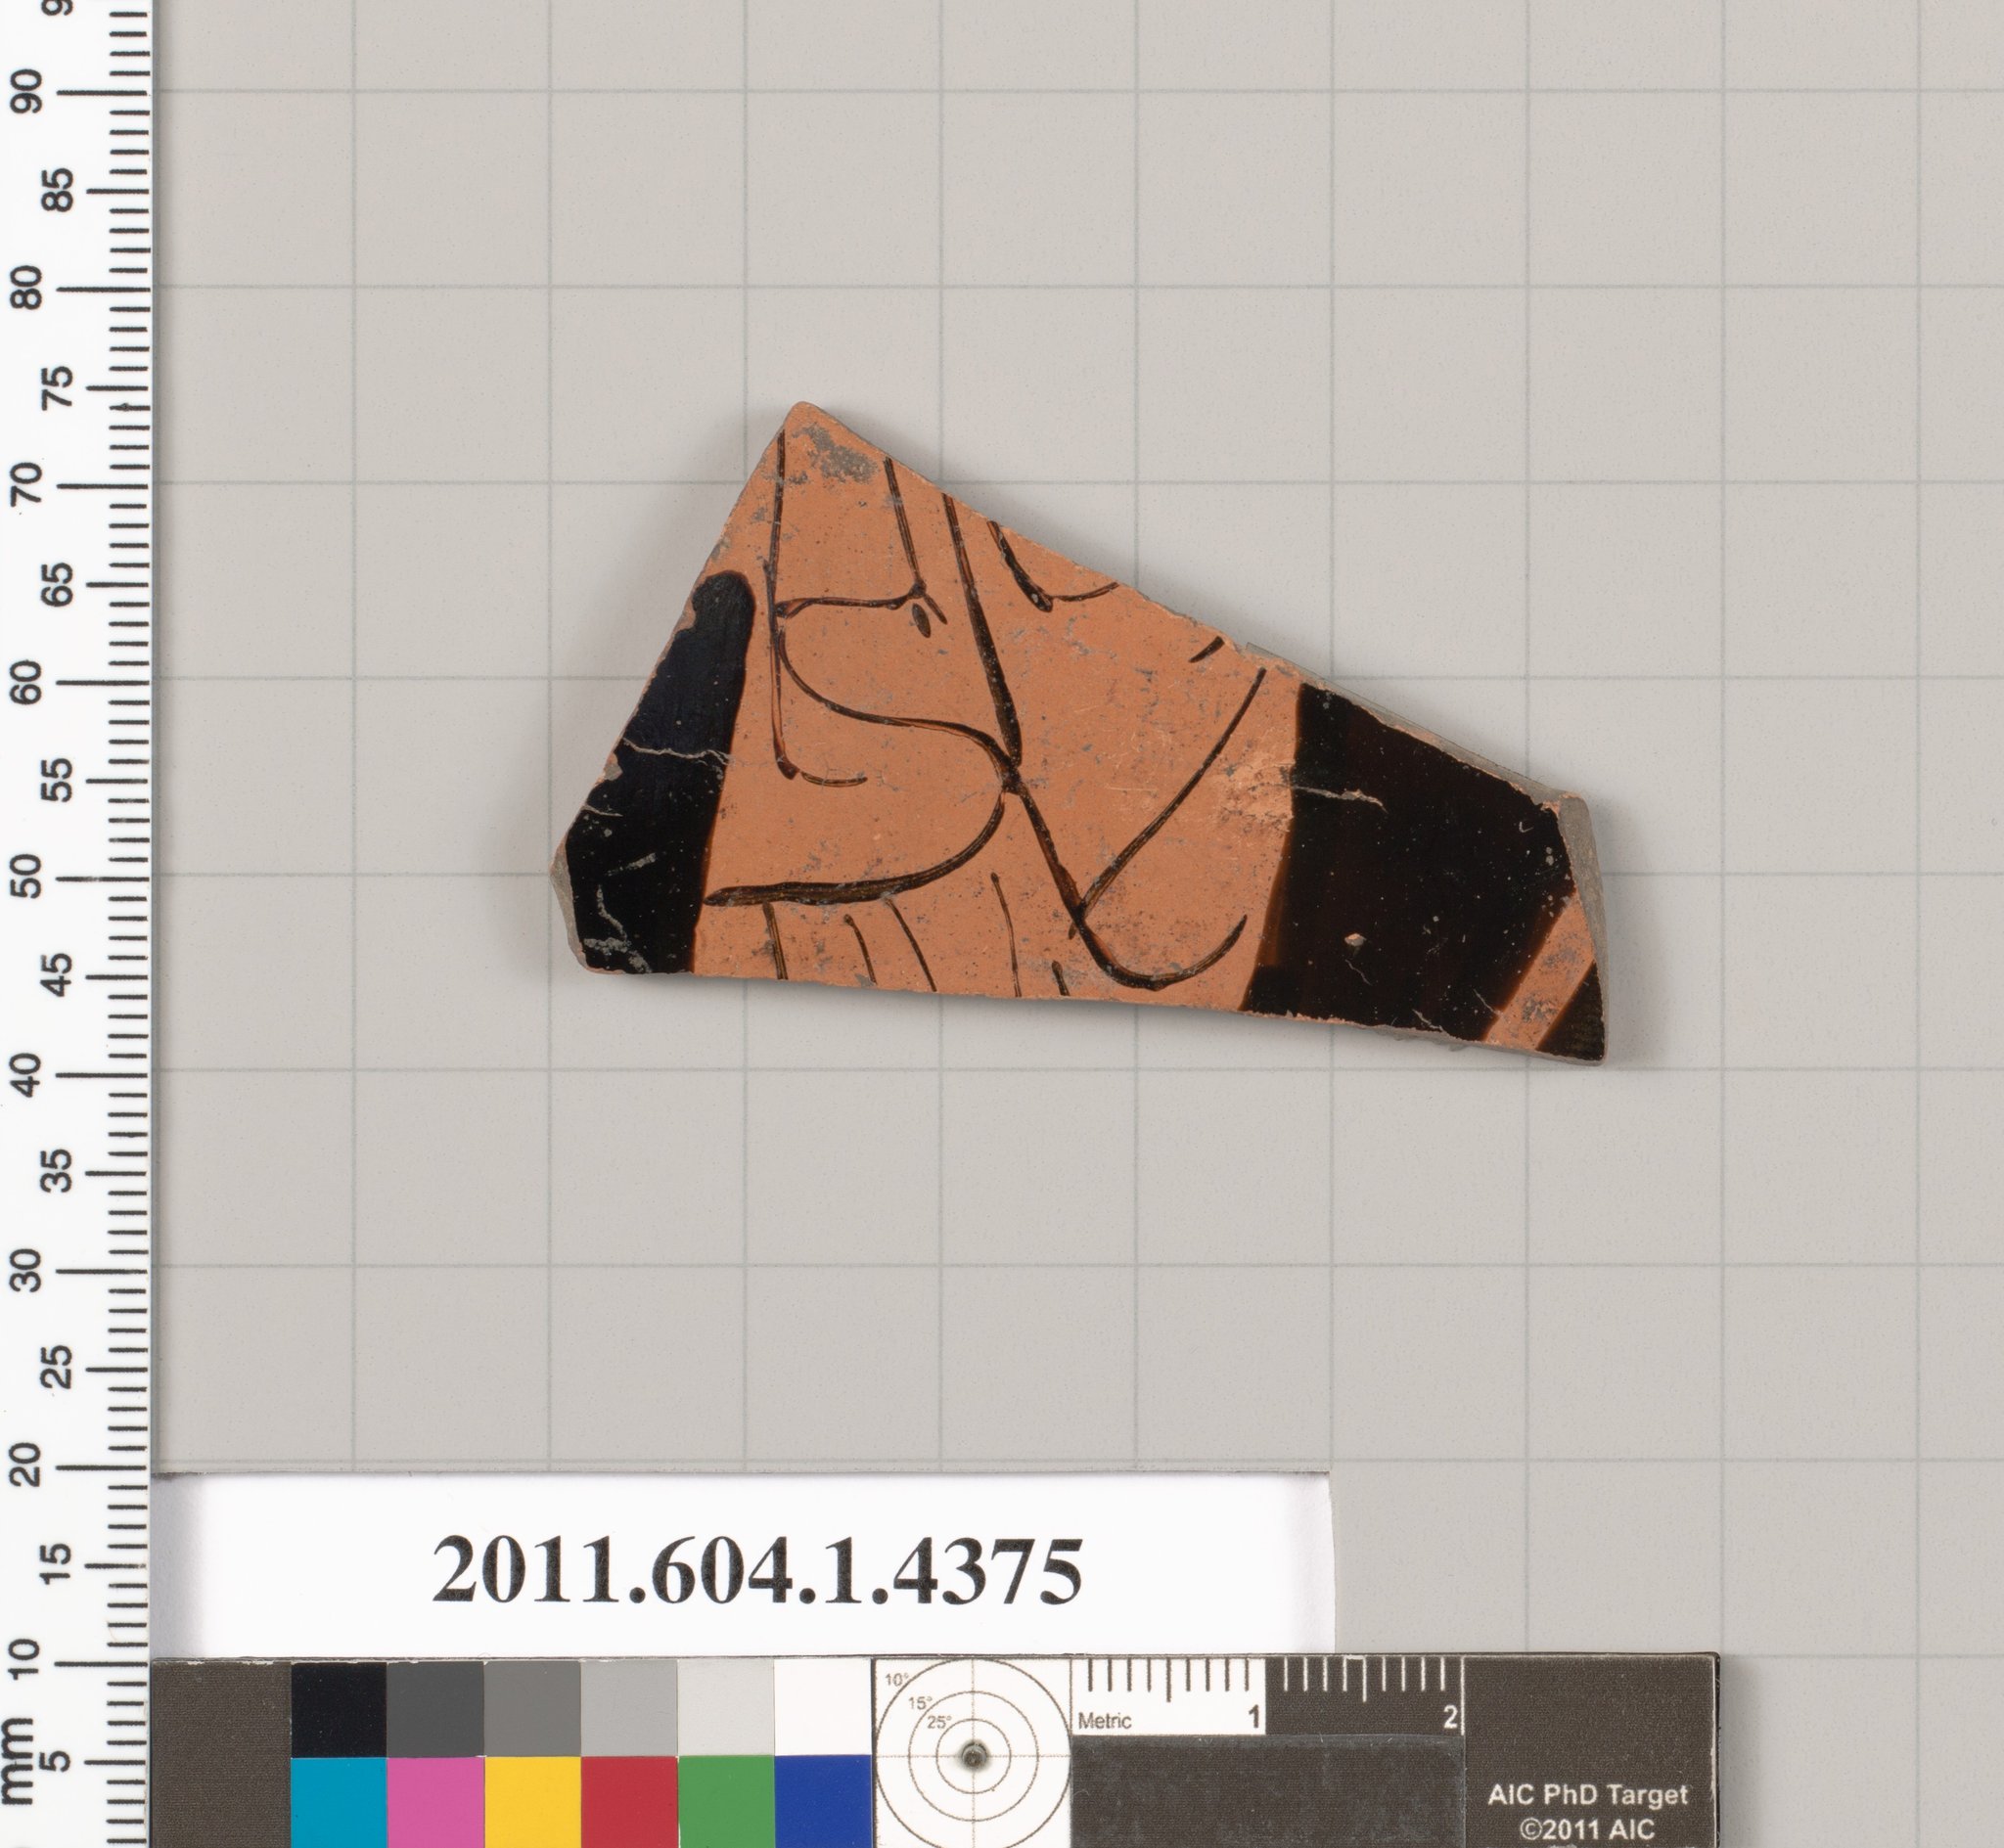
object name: kylix fragment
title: Terracotta fragment of a kylix (drinking cup)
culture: greek, attic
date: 475-451 BCE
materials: terracotta